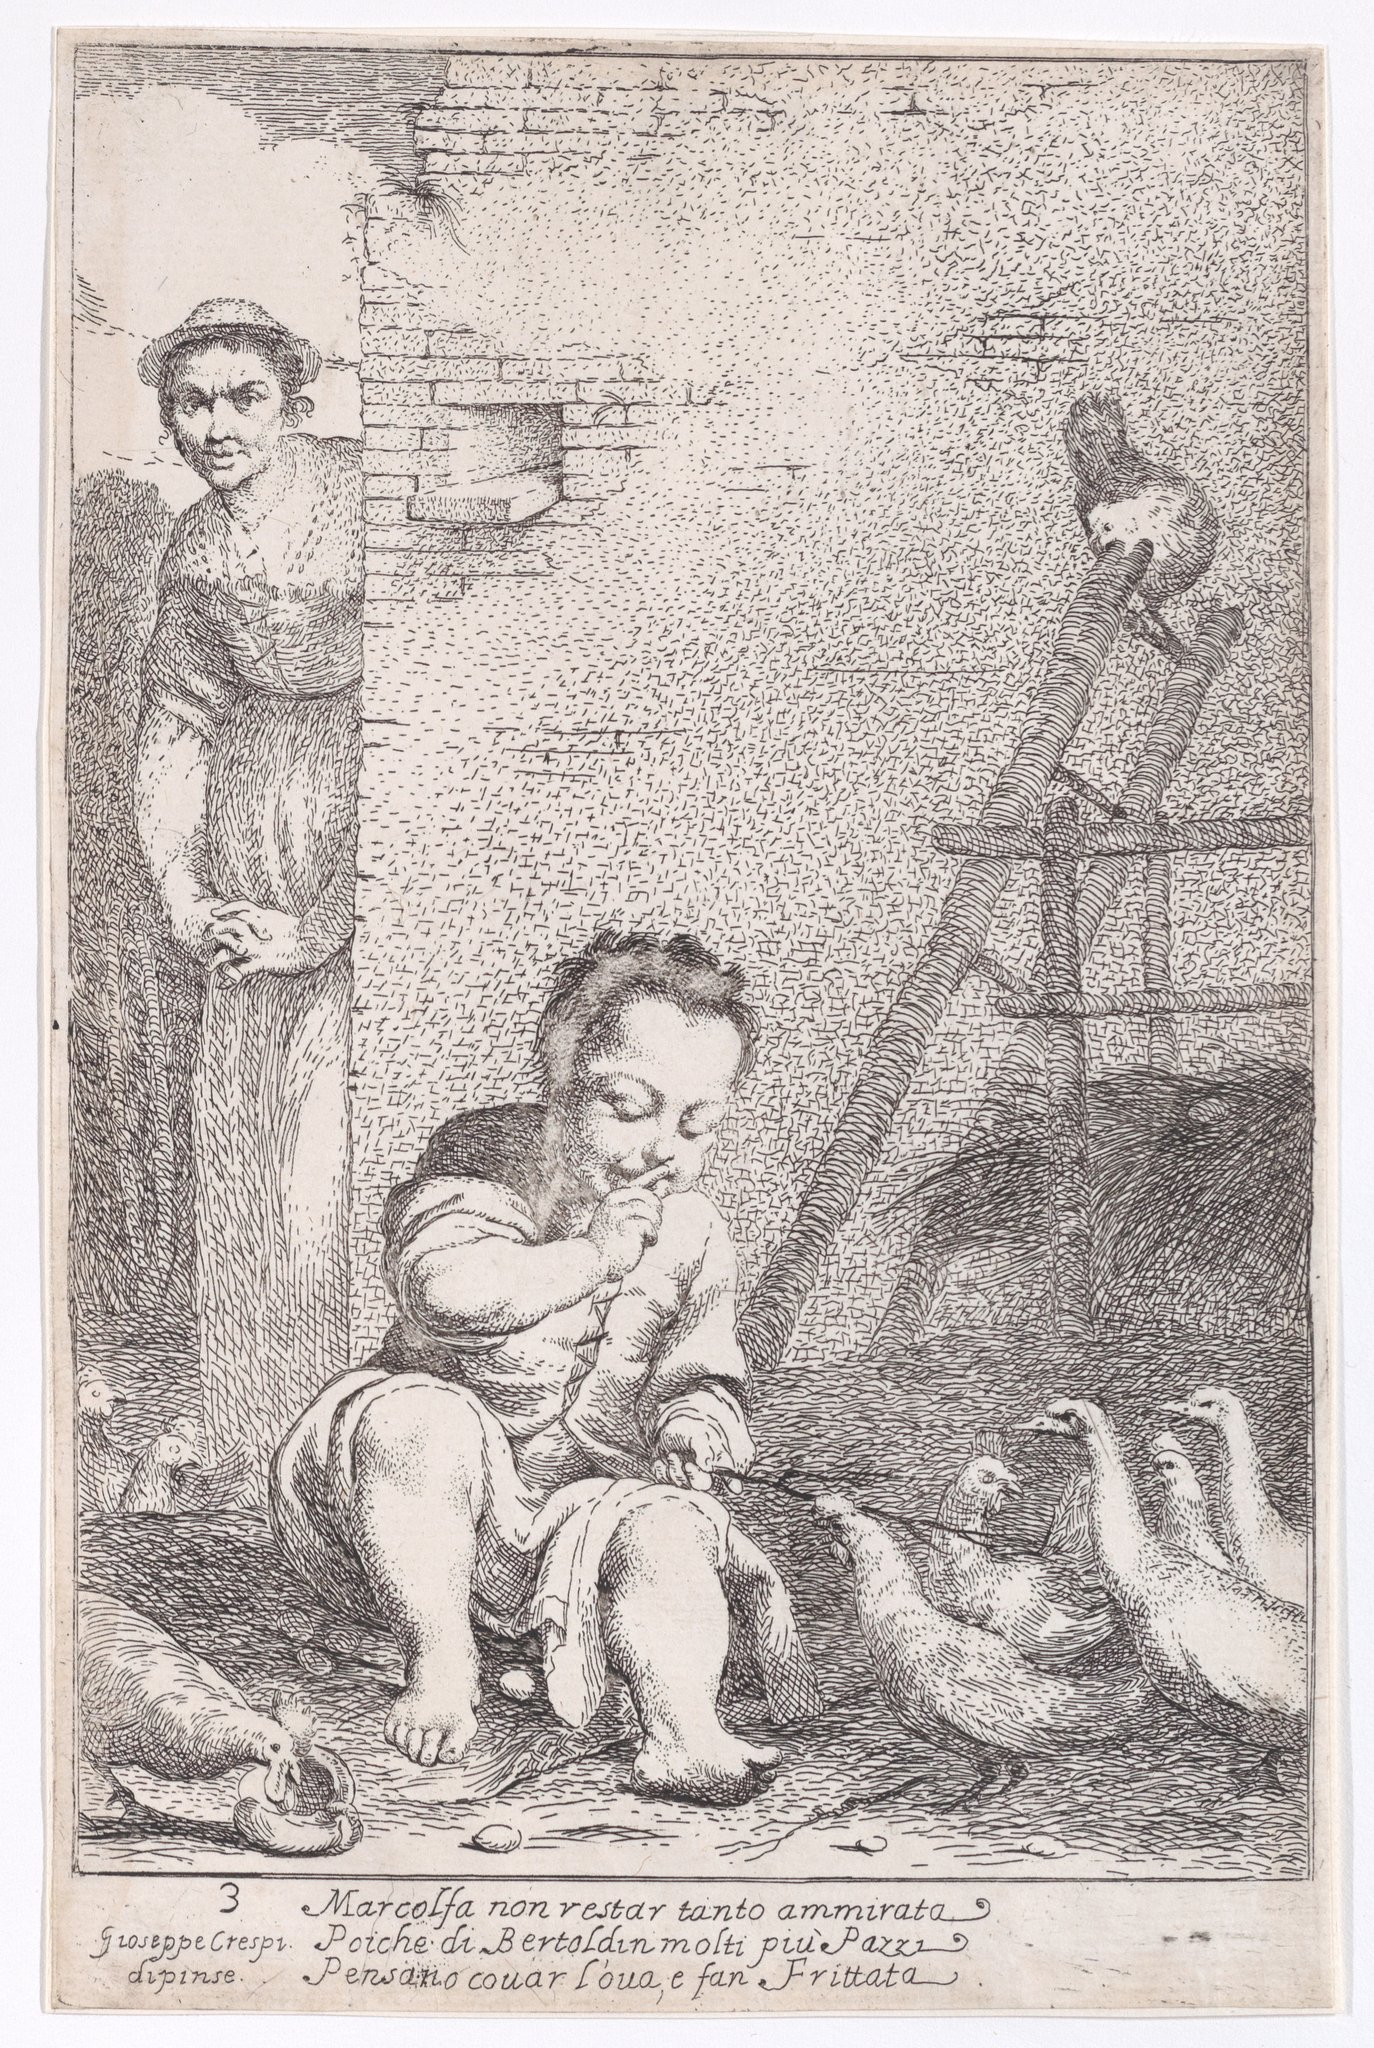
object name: print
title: Plate 9: Marcolfa finds Bertoldino hatching eggs, from "Bertoldo, Bertoldino, and Cacasenno"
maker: giuseppe maria crespi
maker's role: artist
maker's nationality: italian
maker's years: 1665-1747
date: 1705-1715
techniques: etching